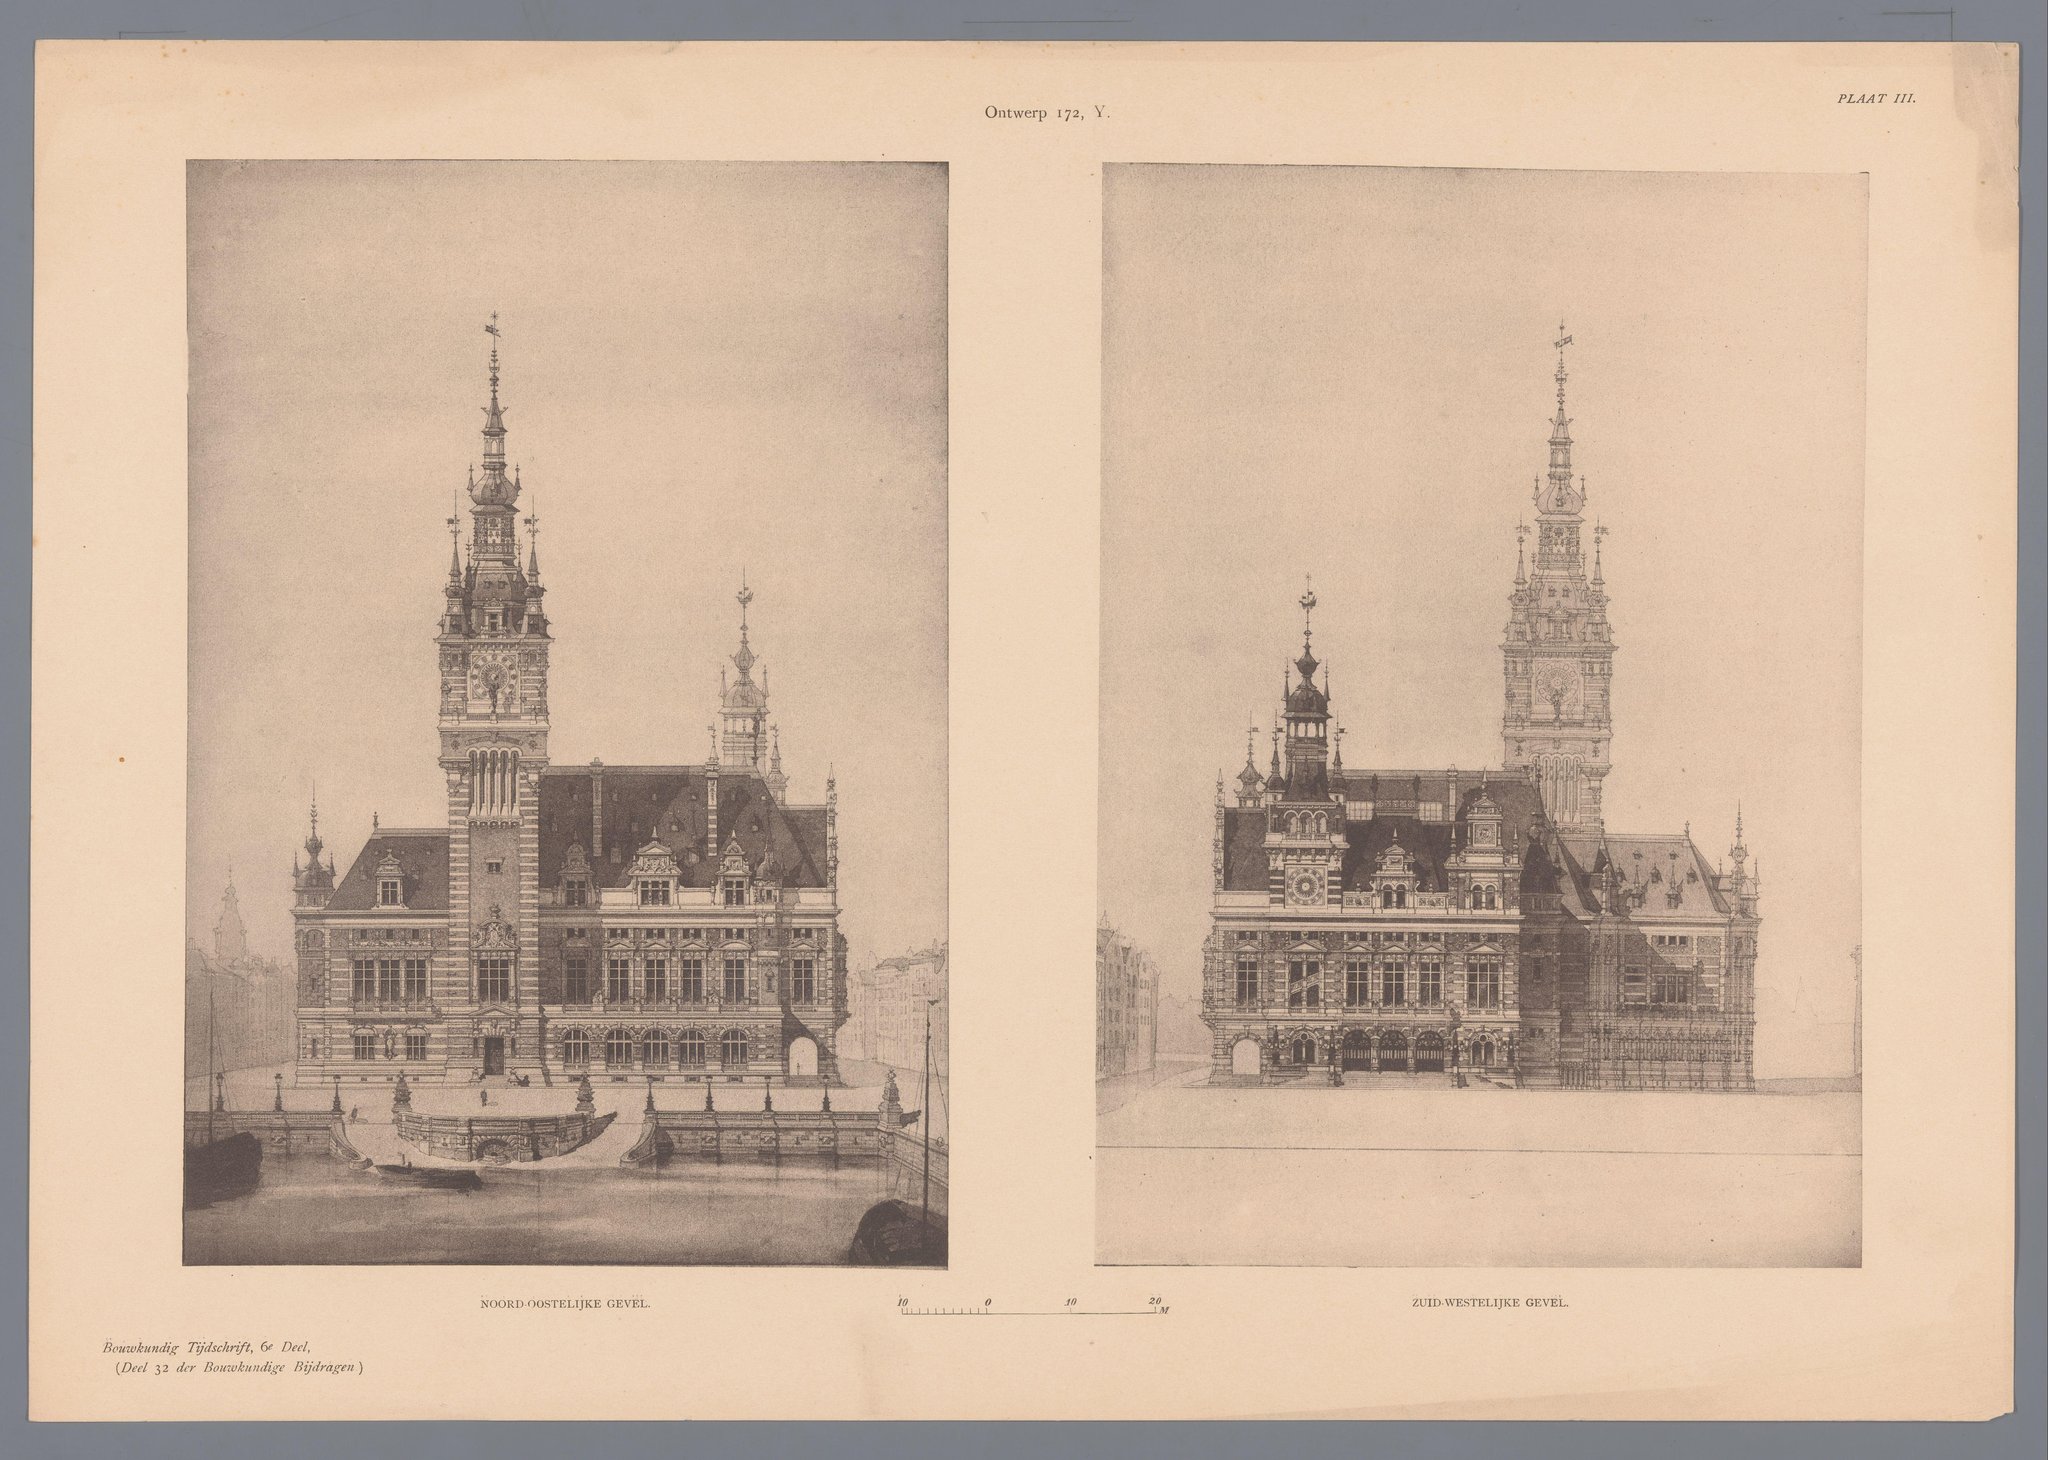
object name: book illustration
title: Ontwerp voor een nieuw beursgebouw in Amsterdam: de noordoostelijke en zuidwestelijke gevel van ontwerp 172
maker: Anonymous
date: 1886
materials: paper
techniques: photograph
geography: amsterdam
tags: market-hall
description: Prent uit: Bouwkundig tijdschrift 6, deel 32 der bouwkundige bijdragen (1886), pl. 3.